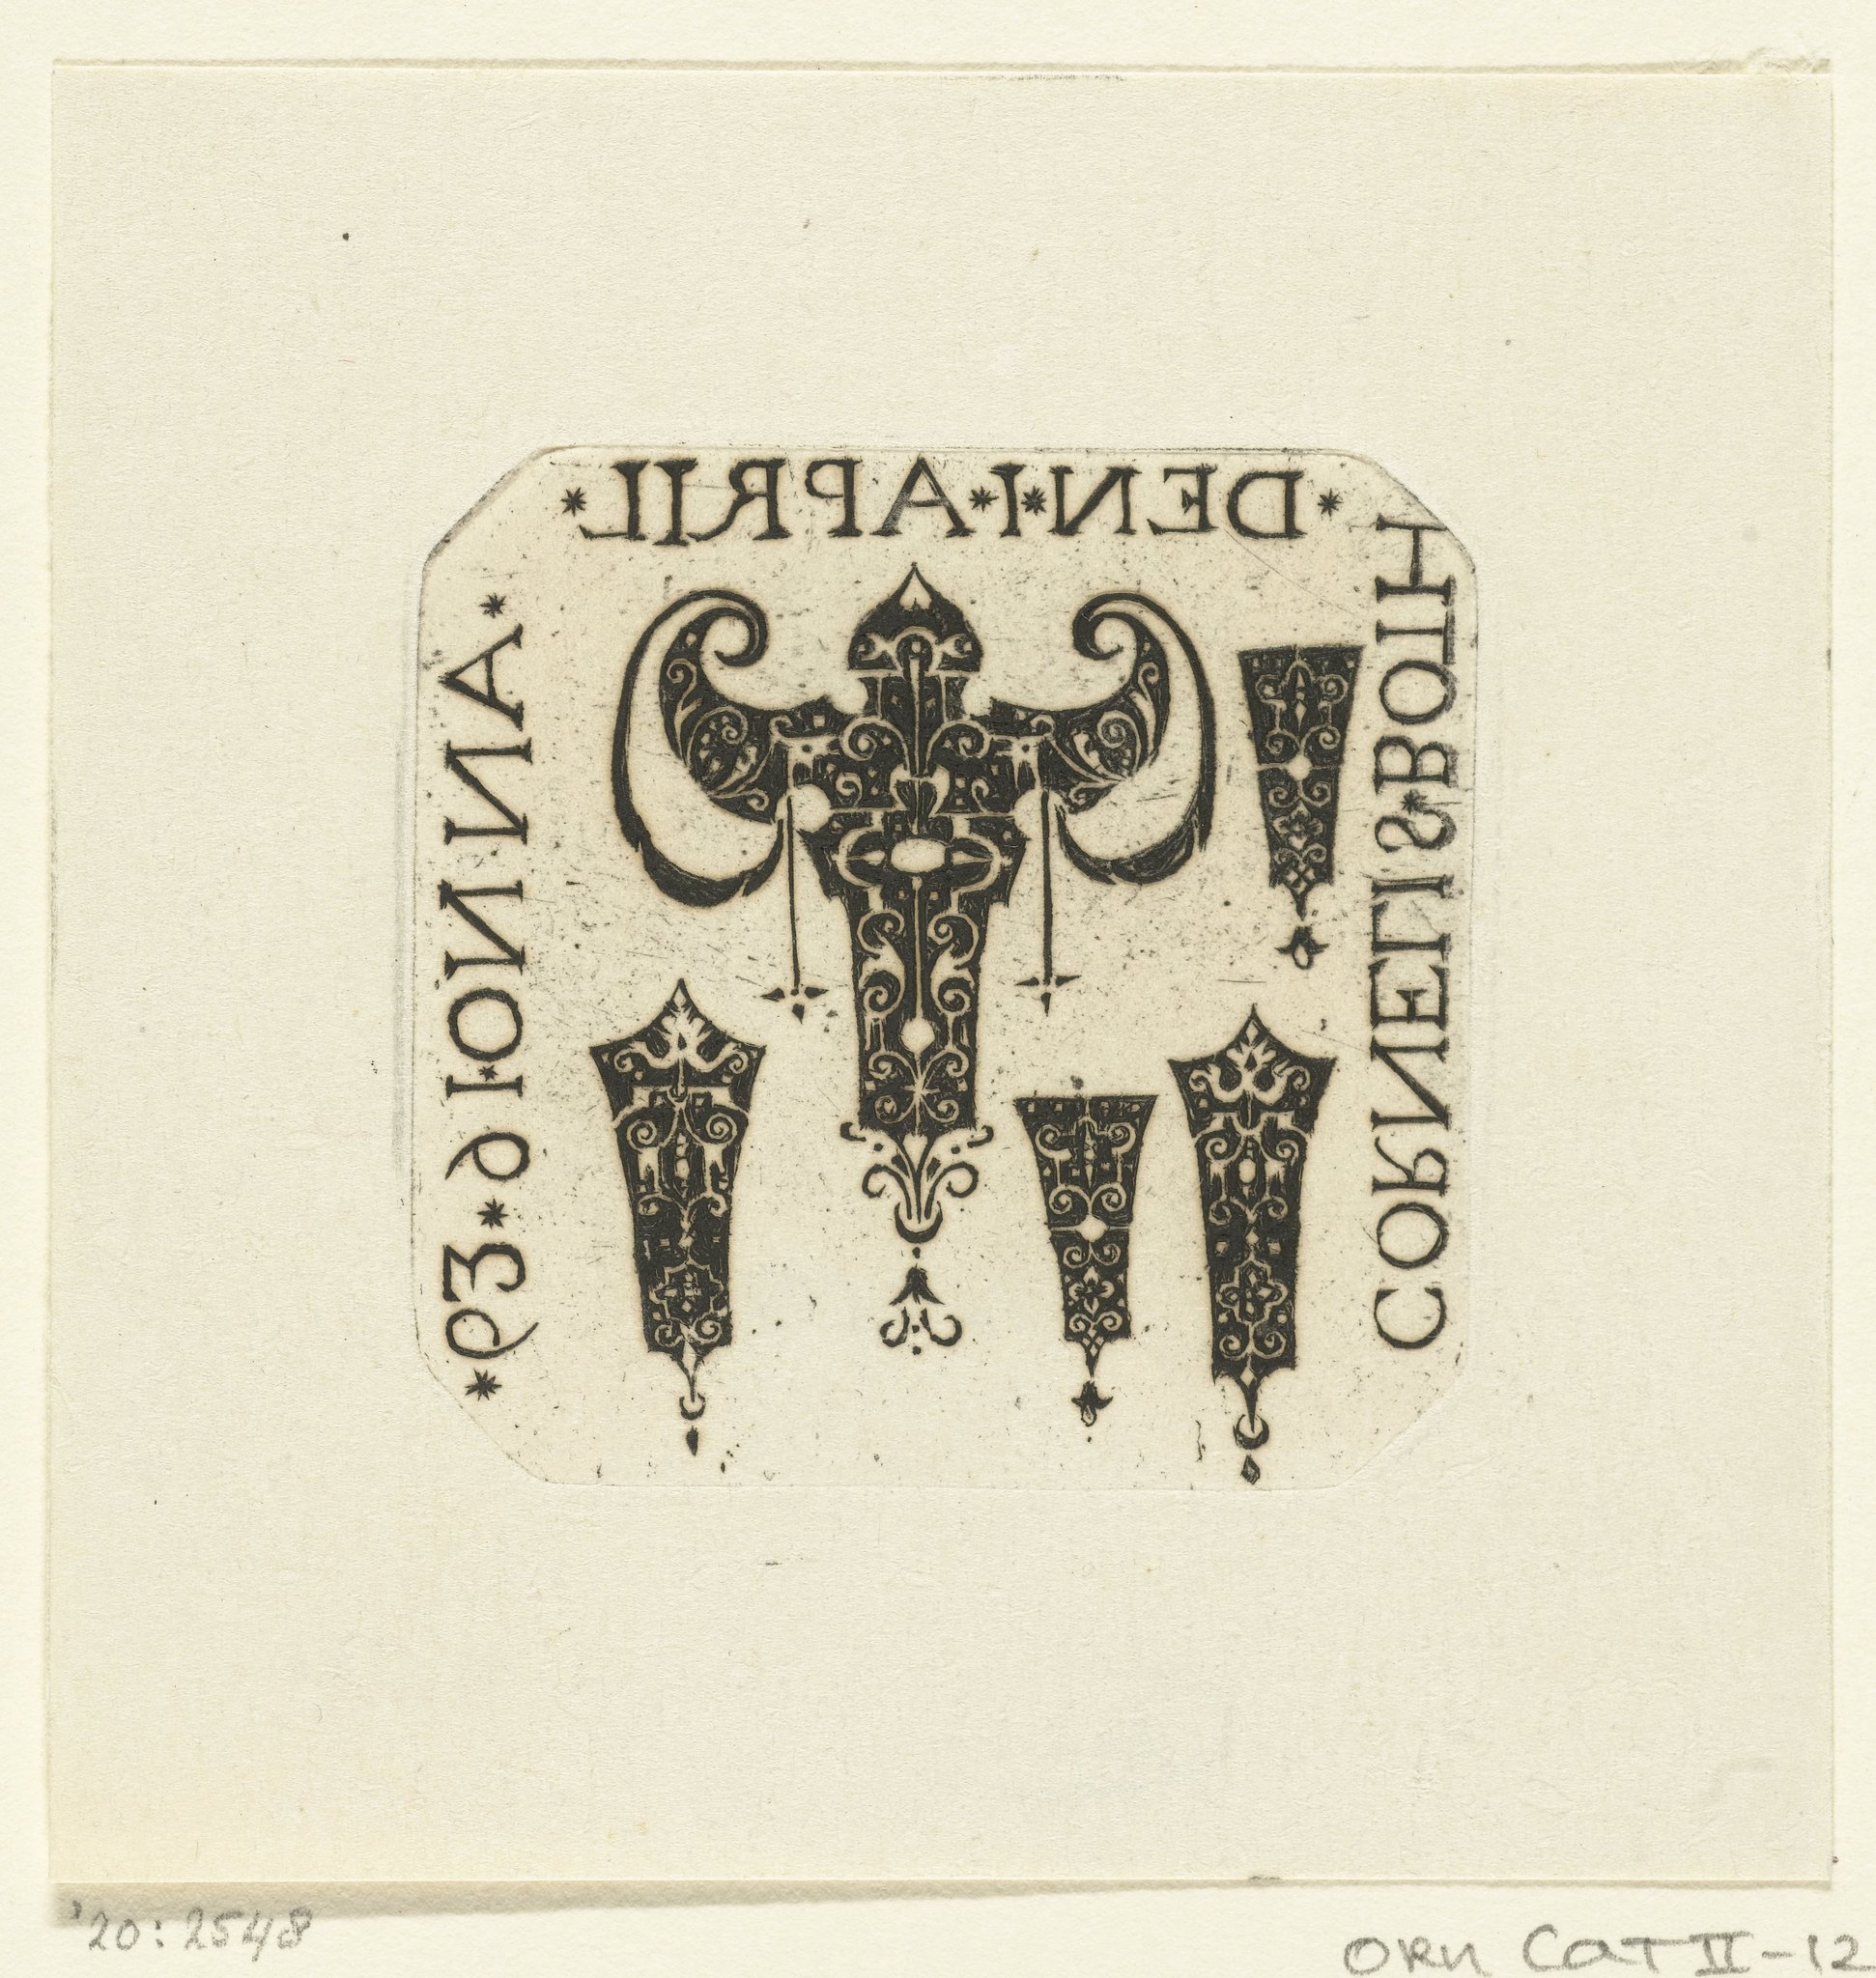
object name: print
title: Five Parts for Rings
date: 1639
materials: paper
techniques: engraving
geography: netherlands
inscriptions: date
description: Rings from the first half of the 17th century are usually still richly ornamented with enamelwork. The shoulder of the ring – next to the setting – was the place to fill in graceful engraving with enamelling. This small print by the otherwise unknown master Cornelis Both presents five different designs.